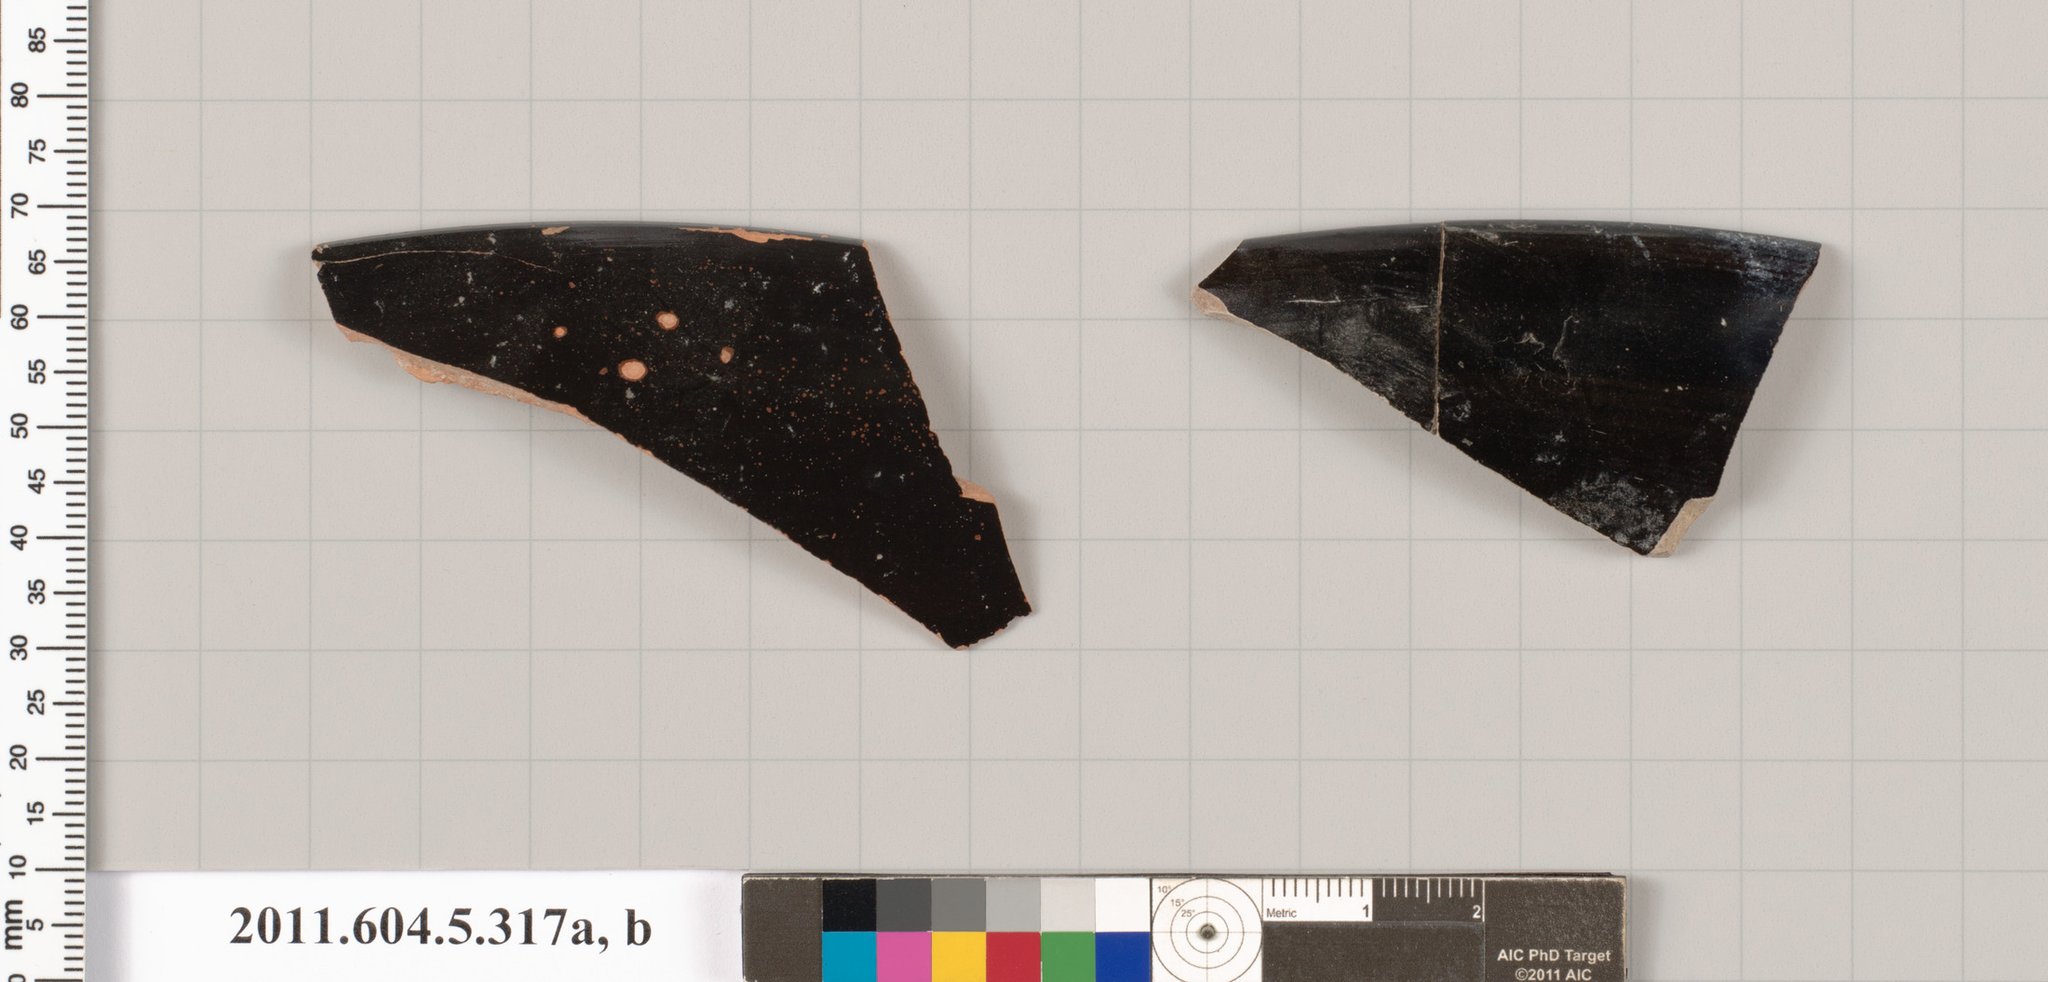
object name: kylix fragment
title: Terracotta rim fragments of kylikes (drinking cups)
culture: greek, attic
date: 600-401 BCE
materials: terracotta